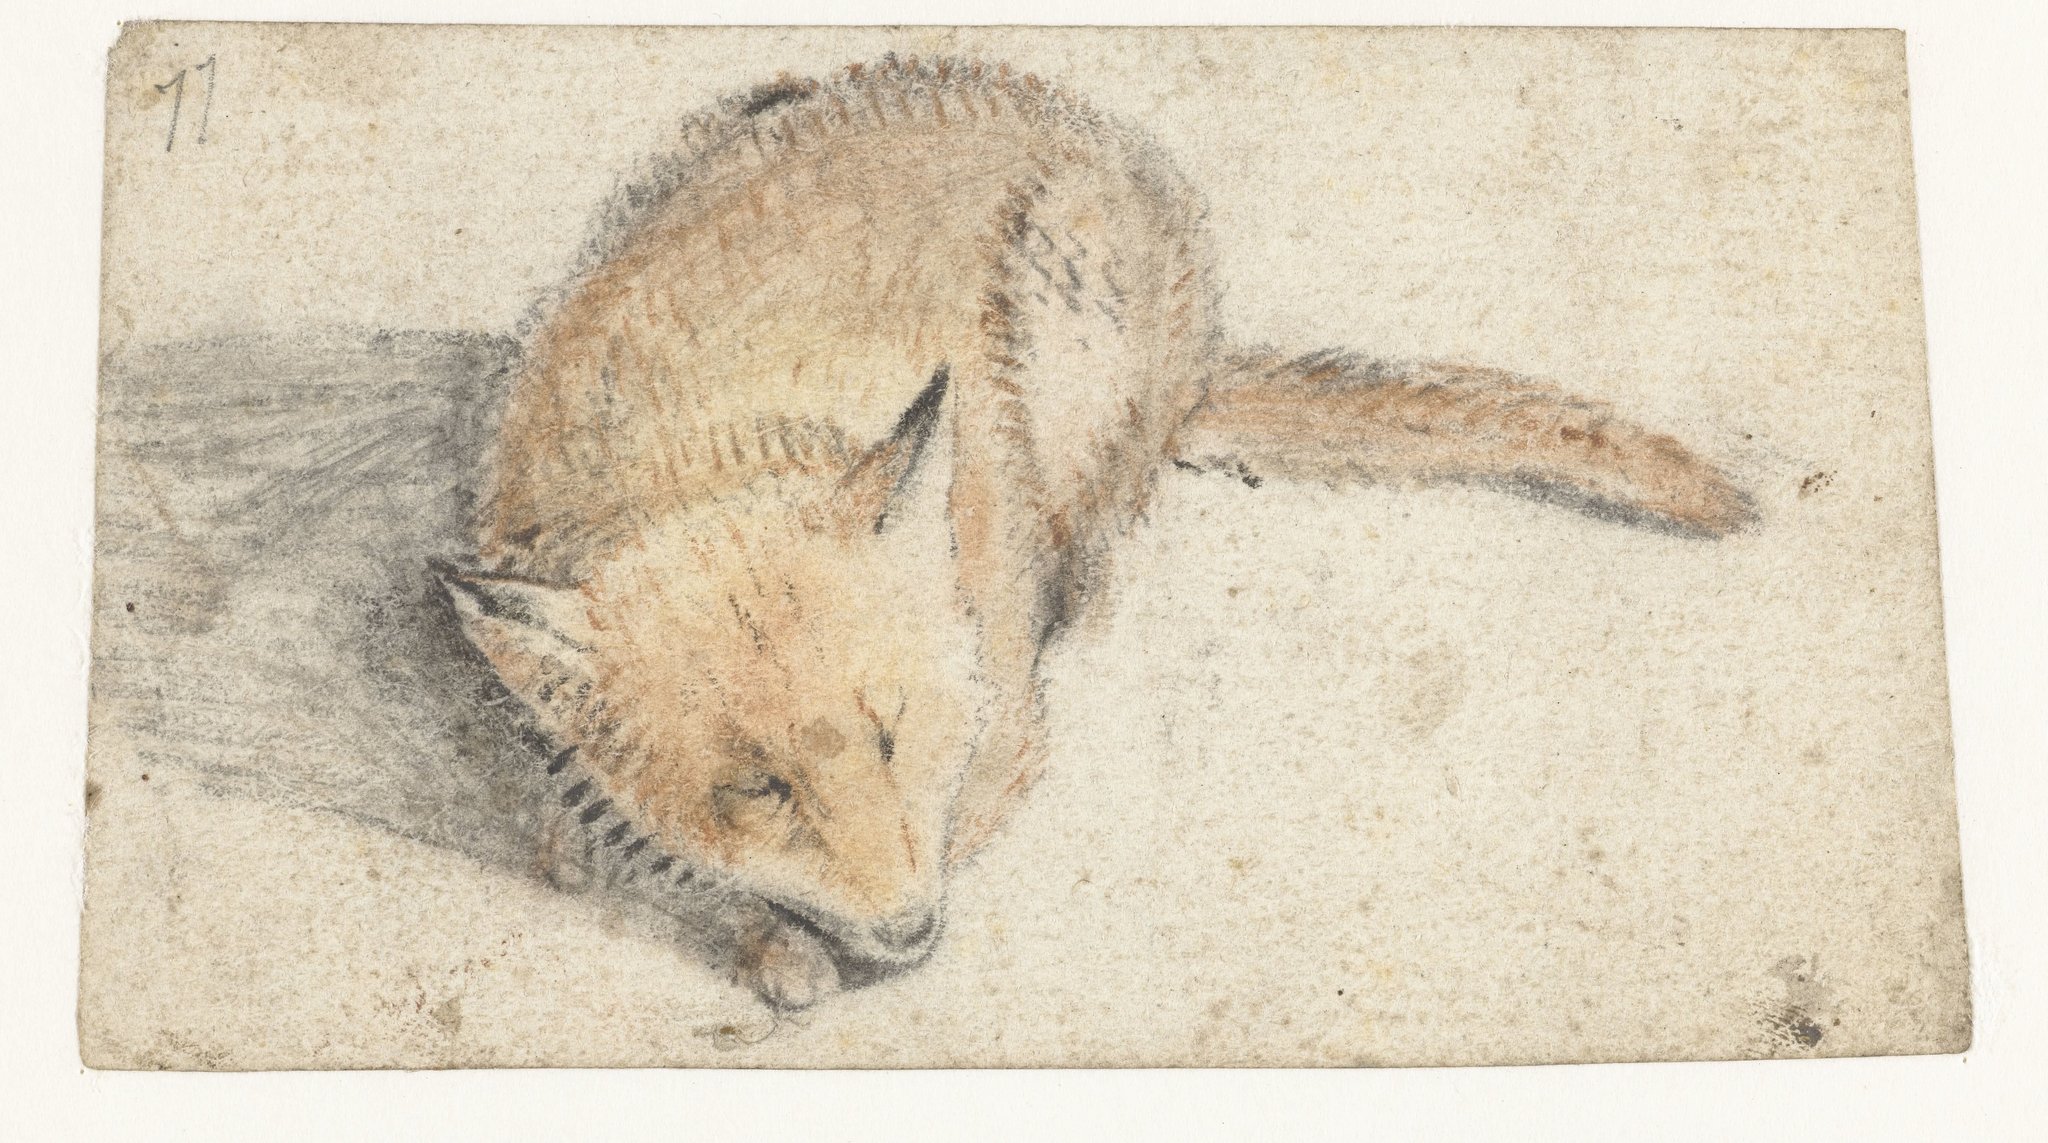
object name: drawing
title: Slapende vos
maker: gerard ter borch (i)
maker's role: draughtsman, print maker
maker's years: 1584-1662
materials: chalk, paper, watercolor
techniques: brush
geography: zwolle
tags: sleeping; unconsciousness